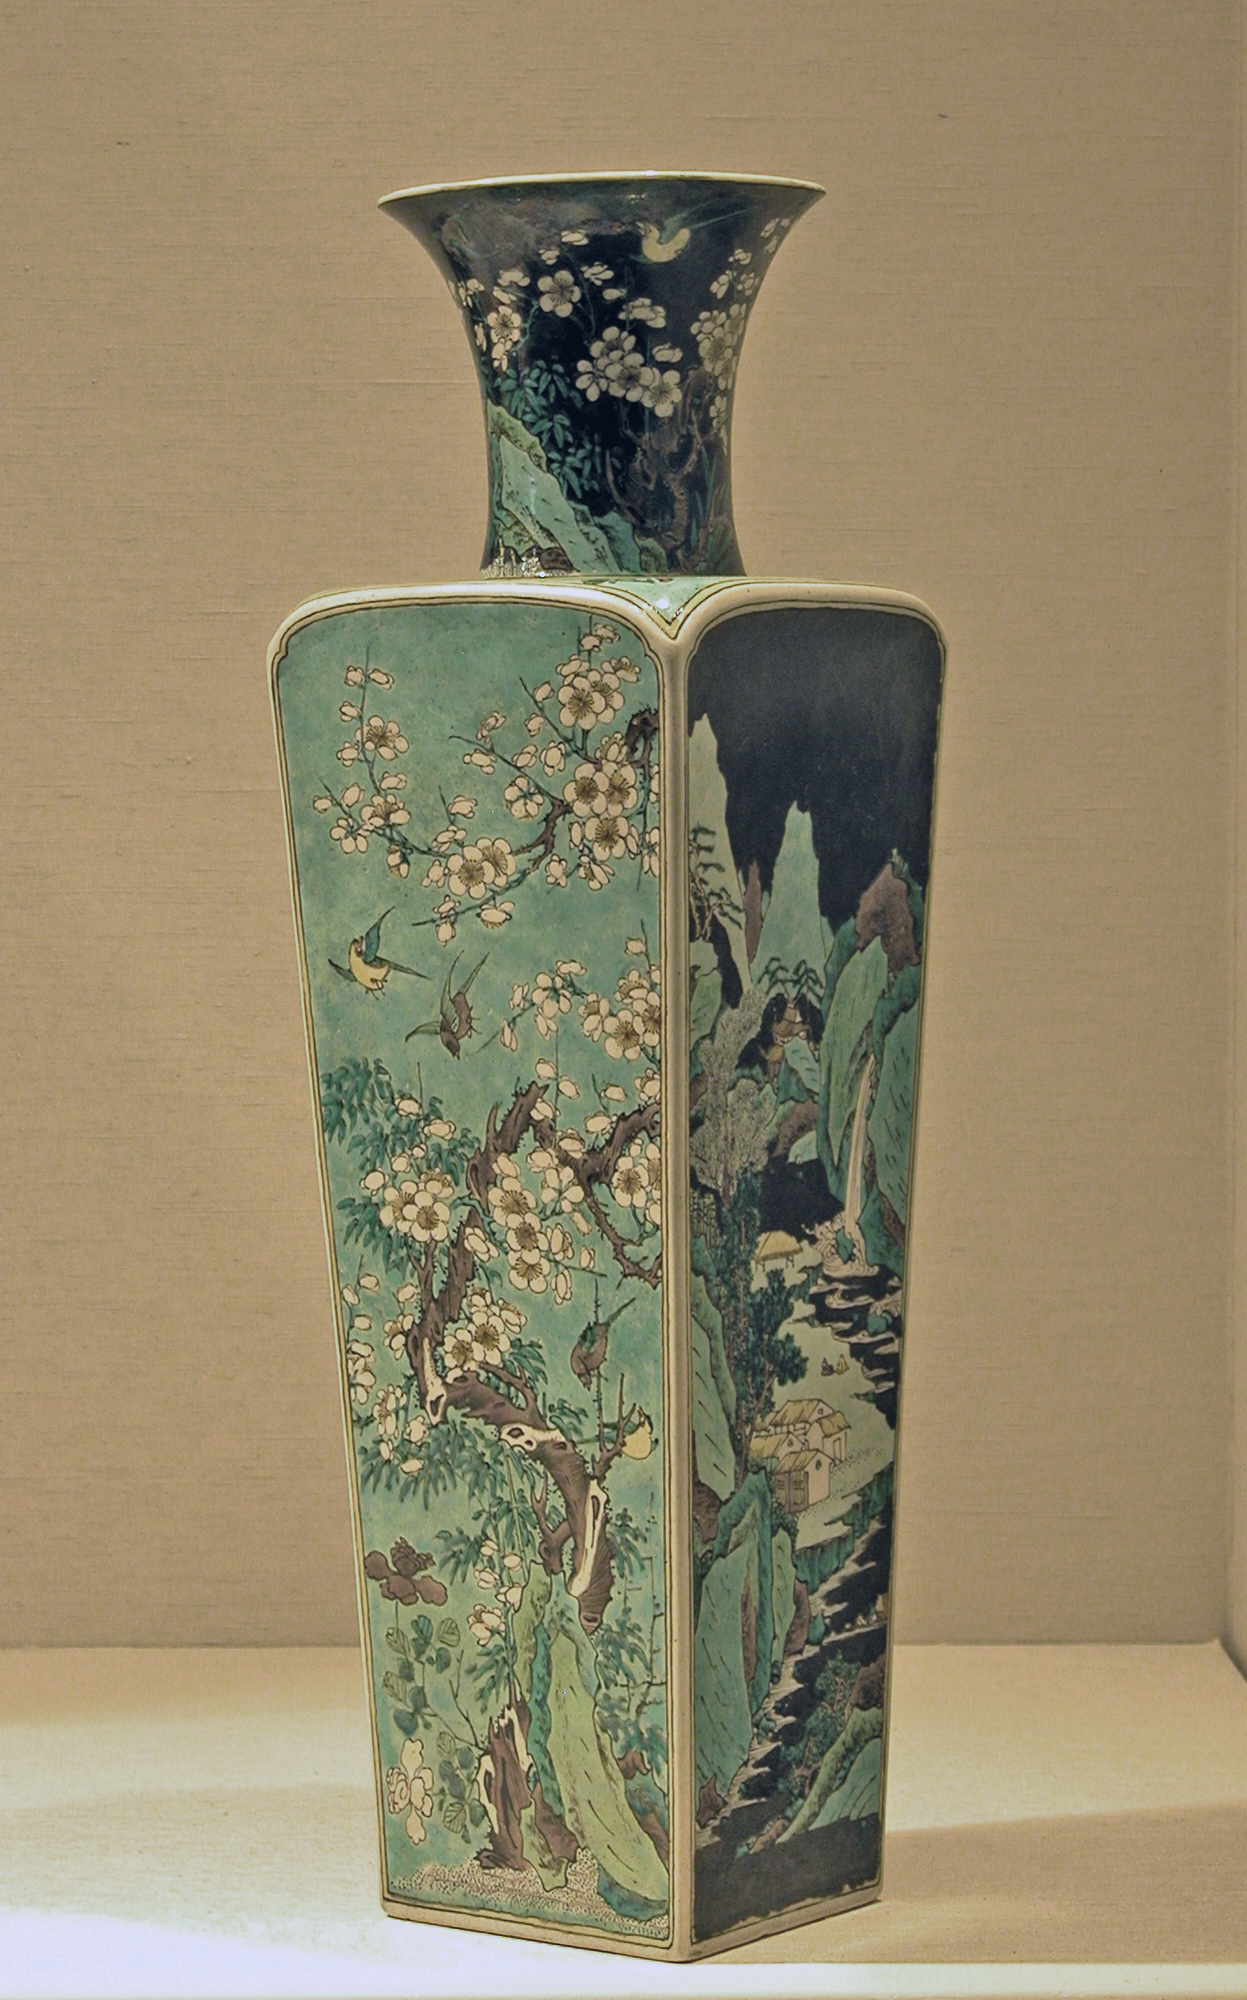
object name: vase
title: Vase with alternating landscape and floral scenes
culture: chinese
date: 1801-1900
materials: enamel, porcelain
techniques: painting, polychrome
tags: birds,flowers,landscapes